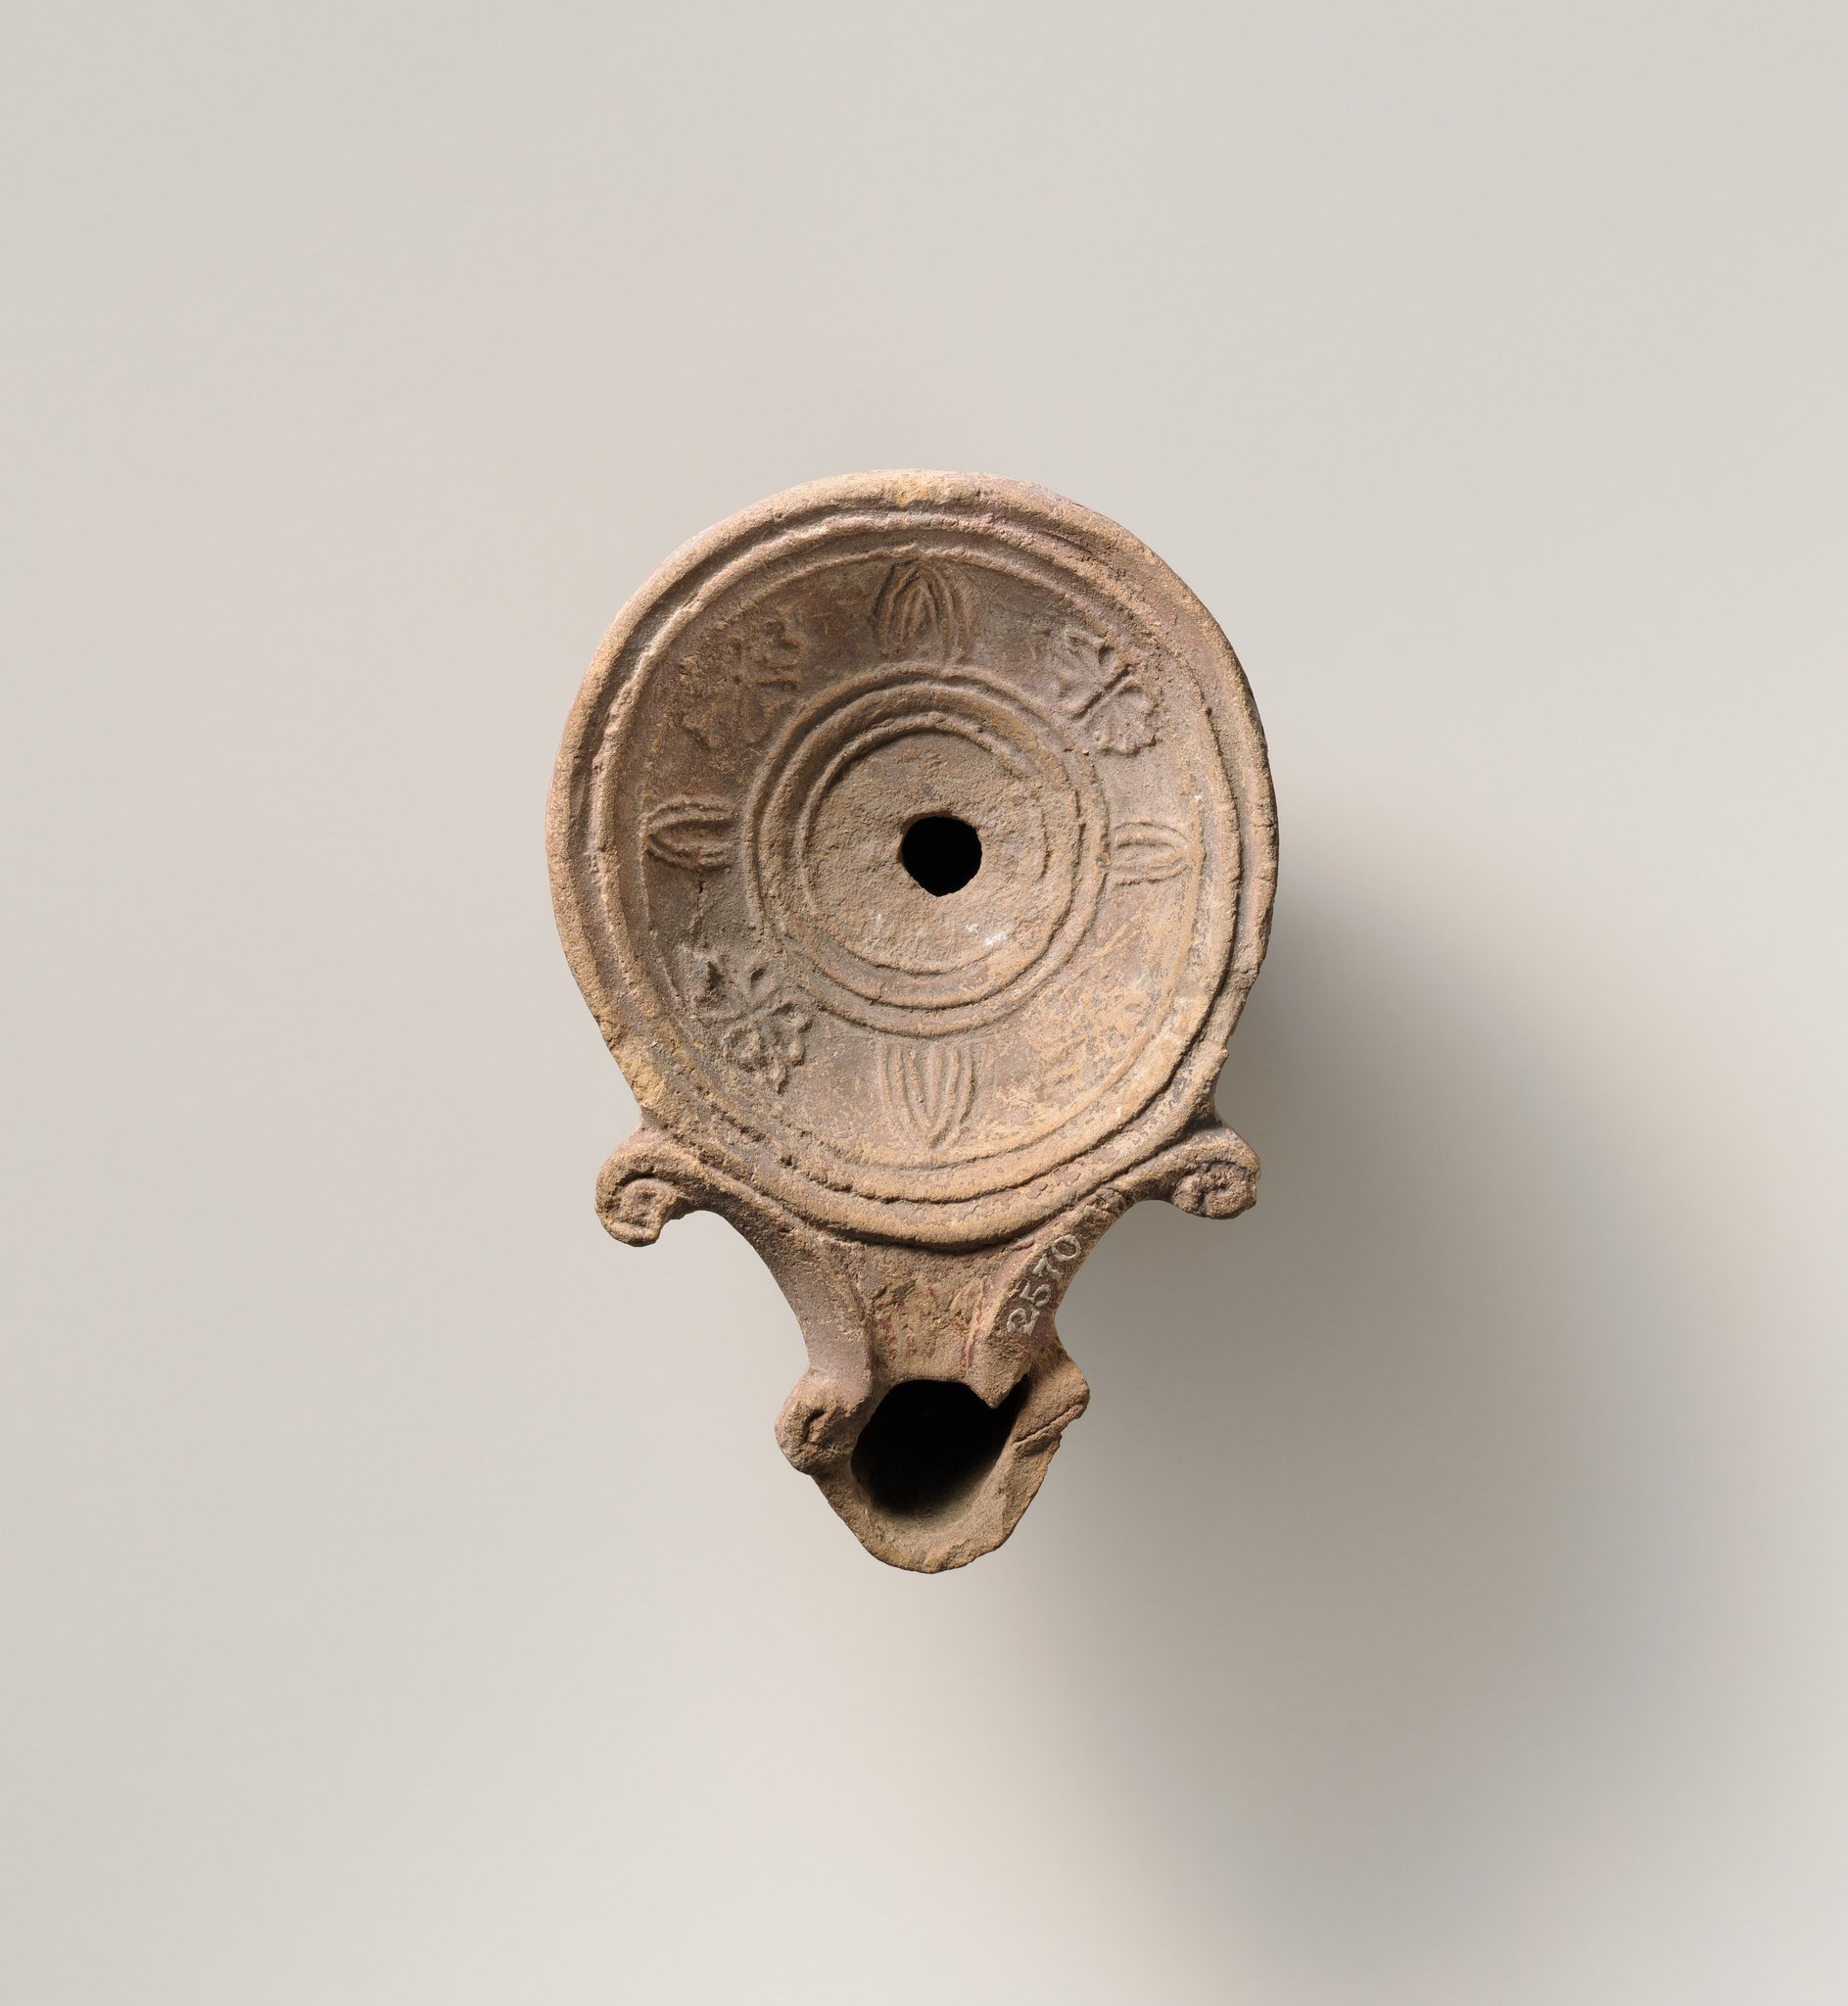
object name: lamp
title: Terracotta oil lamp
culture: roman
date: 1-100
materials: terracotta